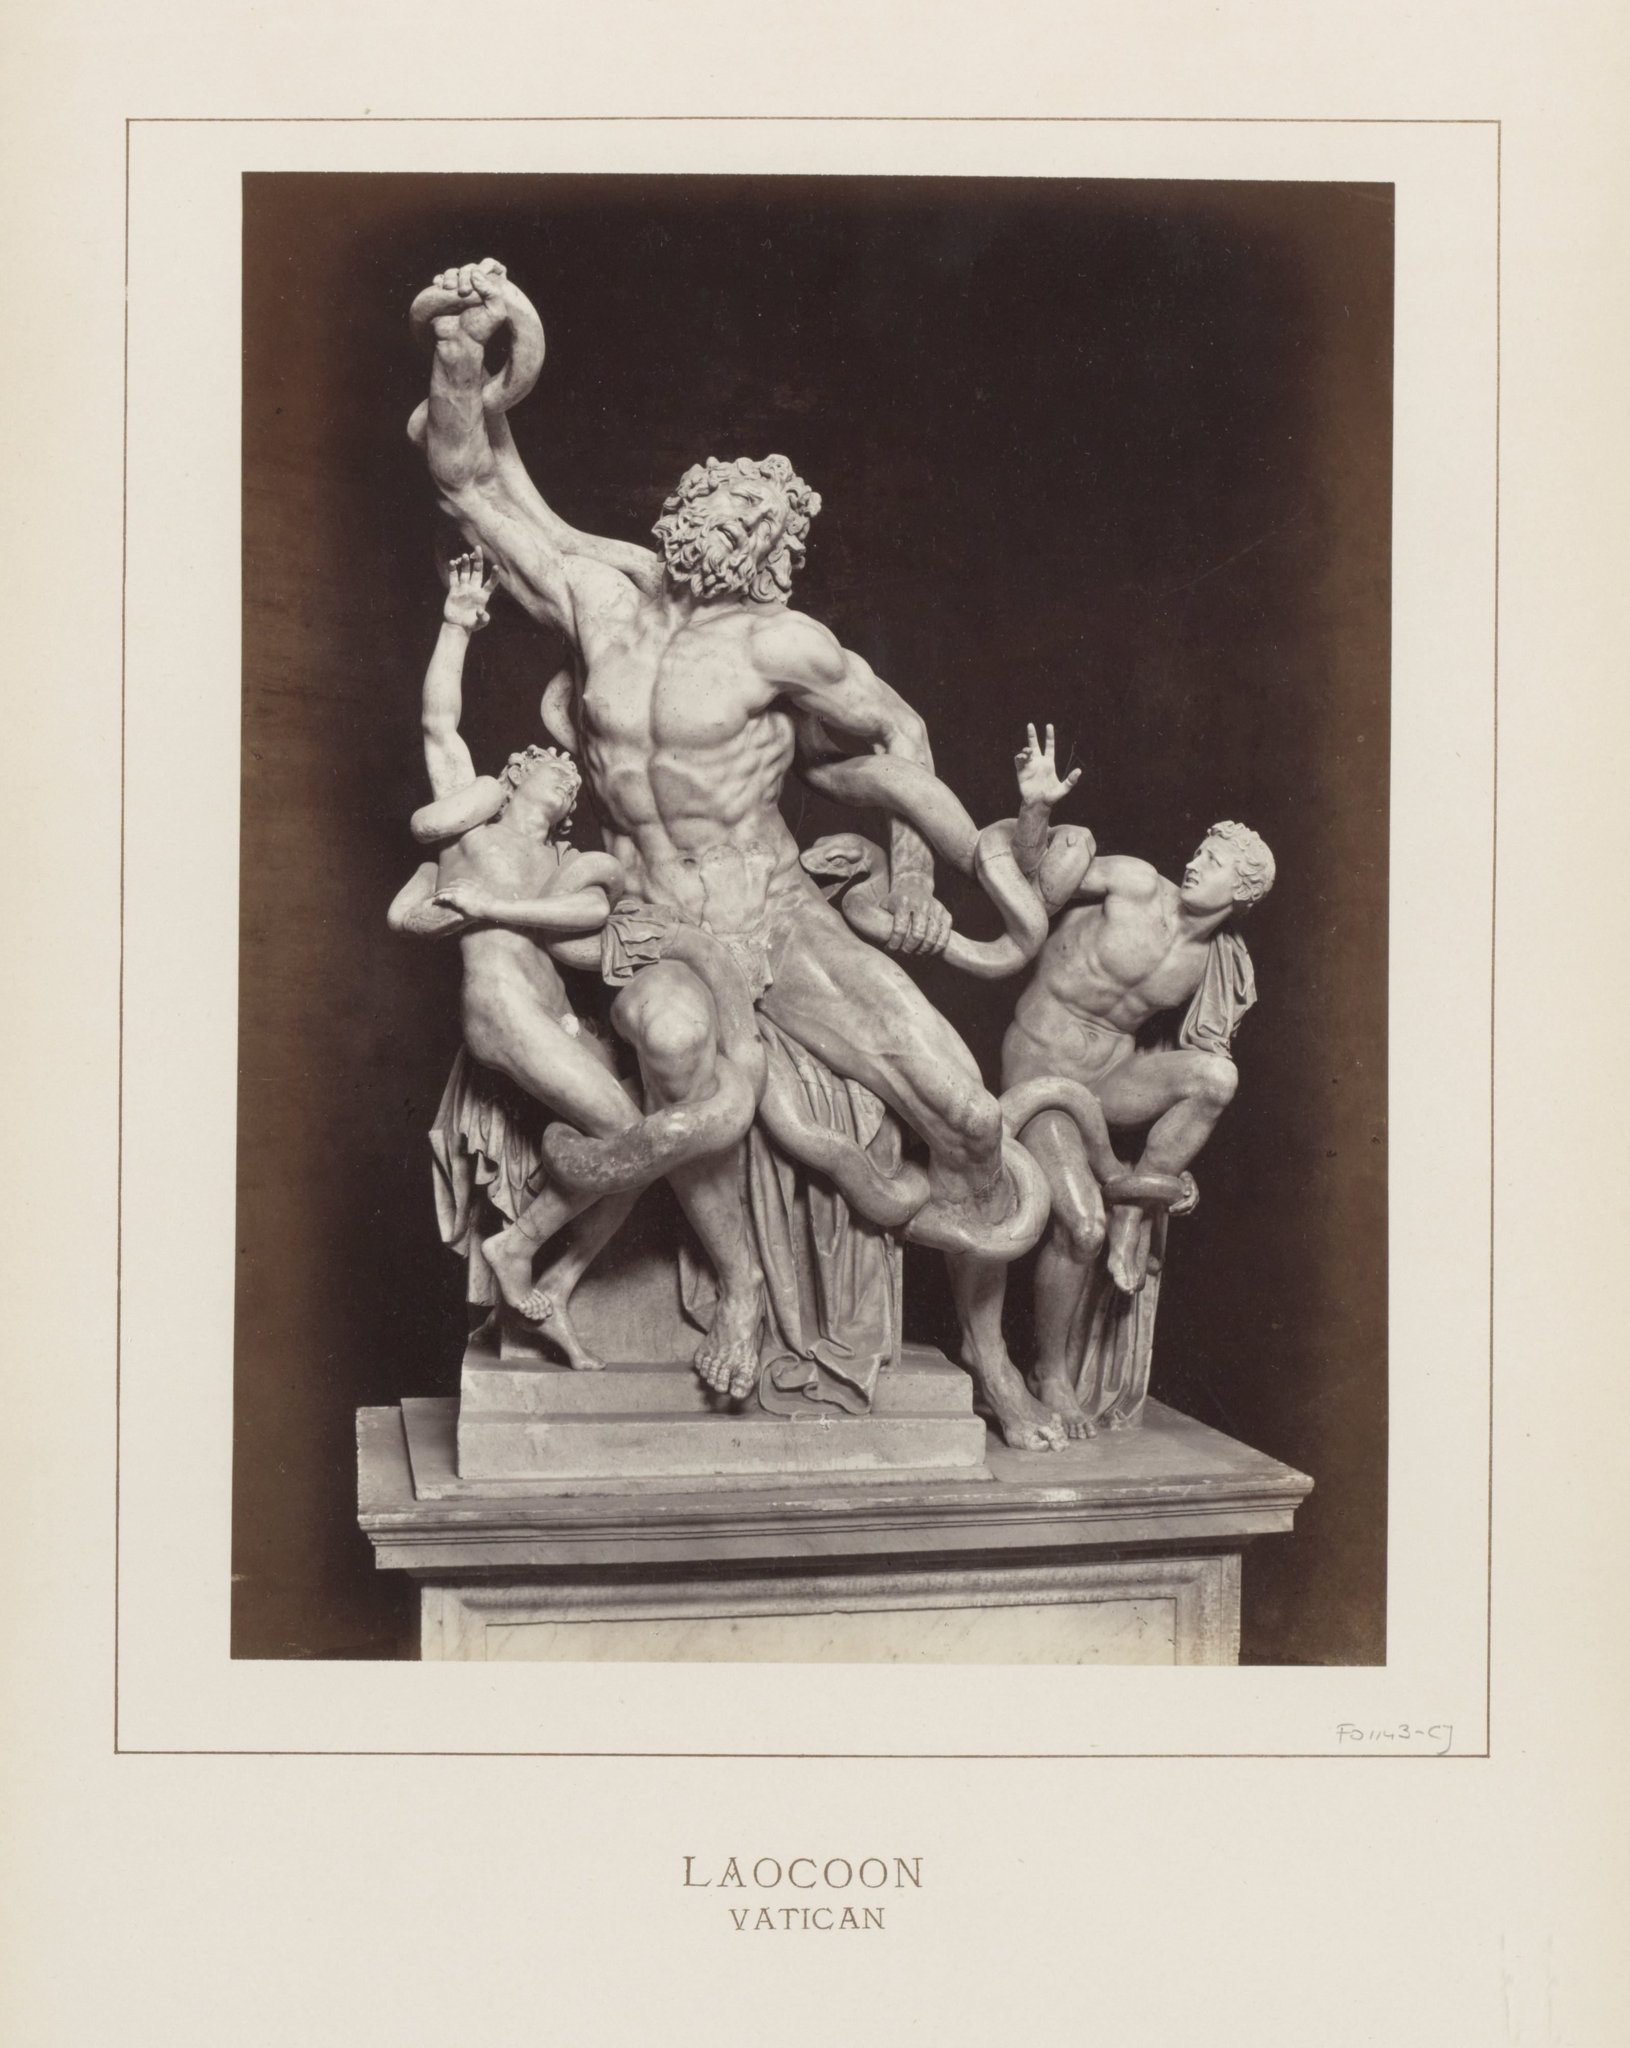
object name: photograph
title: Laocoon, Vatican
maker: Anonymous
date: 1860-1900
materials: photographic support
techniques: albumen print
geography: vatican city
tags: laocoon and his twin sons are strangled by two serpents during the preparations for a sacrifice, piece of sculpture, reproduction of a piece of sculpture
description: Onderdeel van Fotoalbum met opnames van bezienswaardigheden en kunstwerken in Rome.